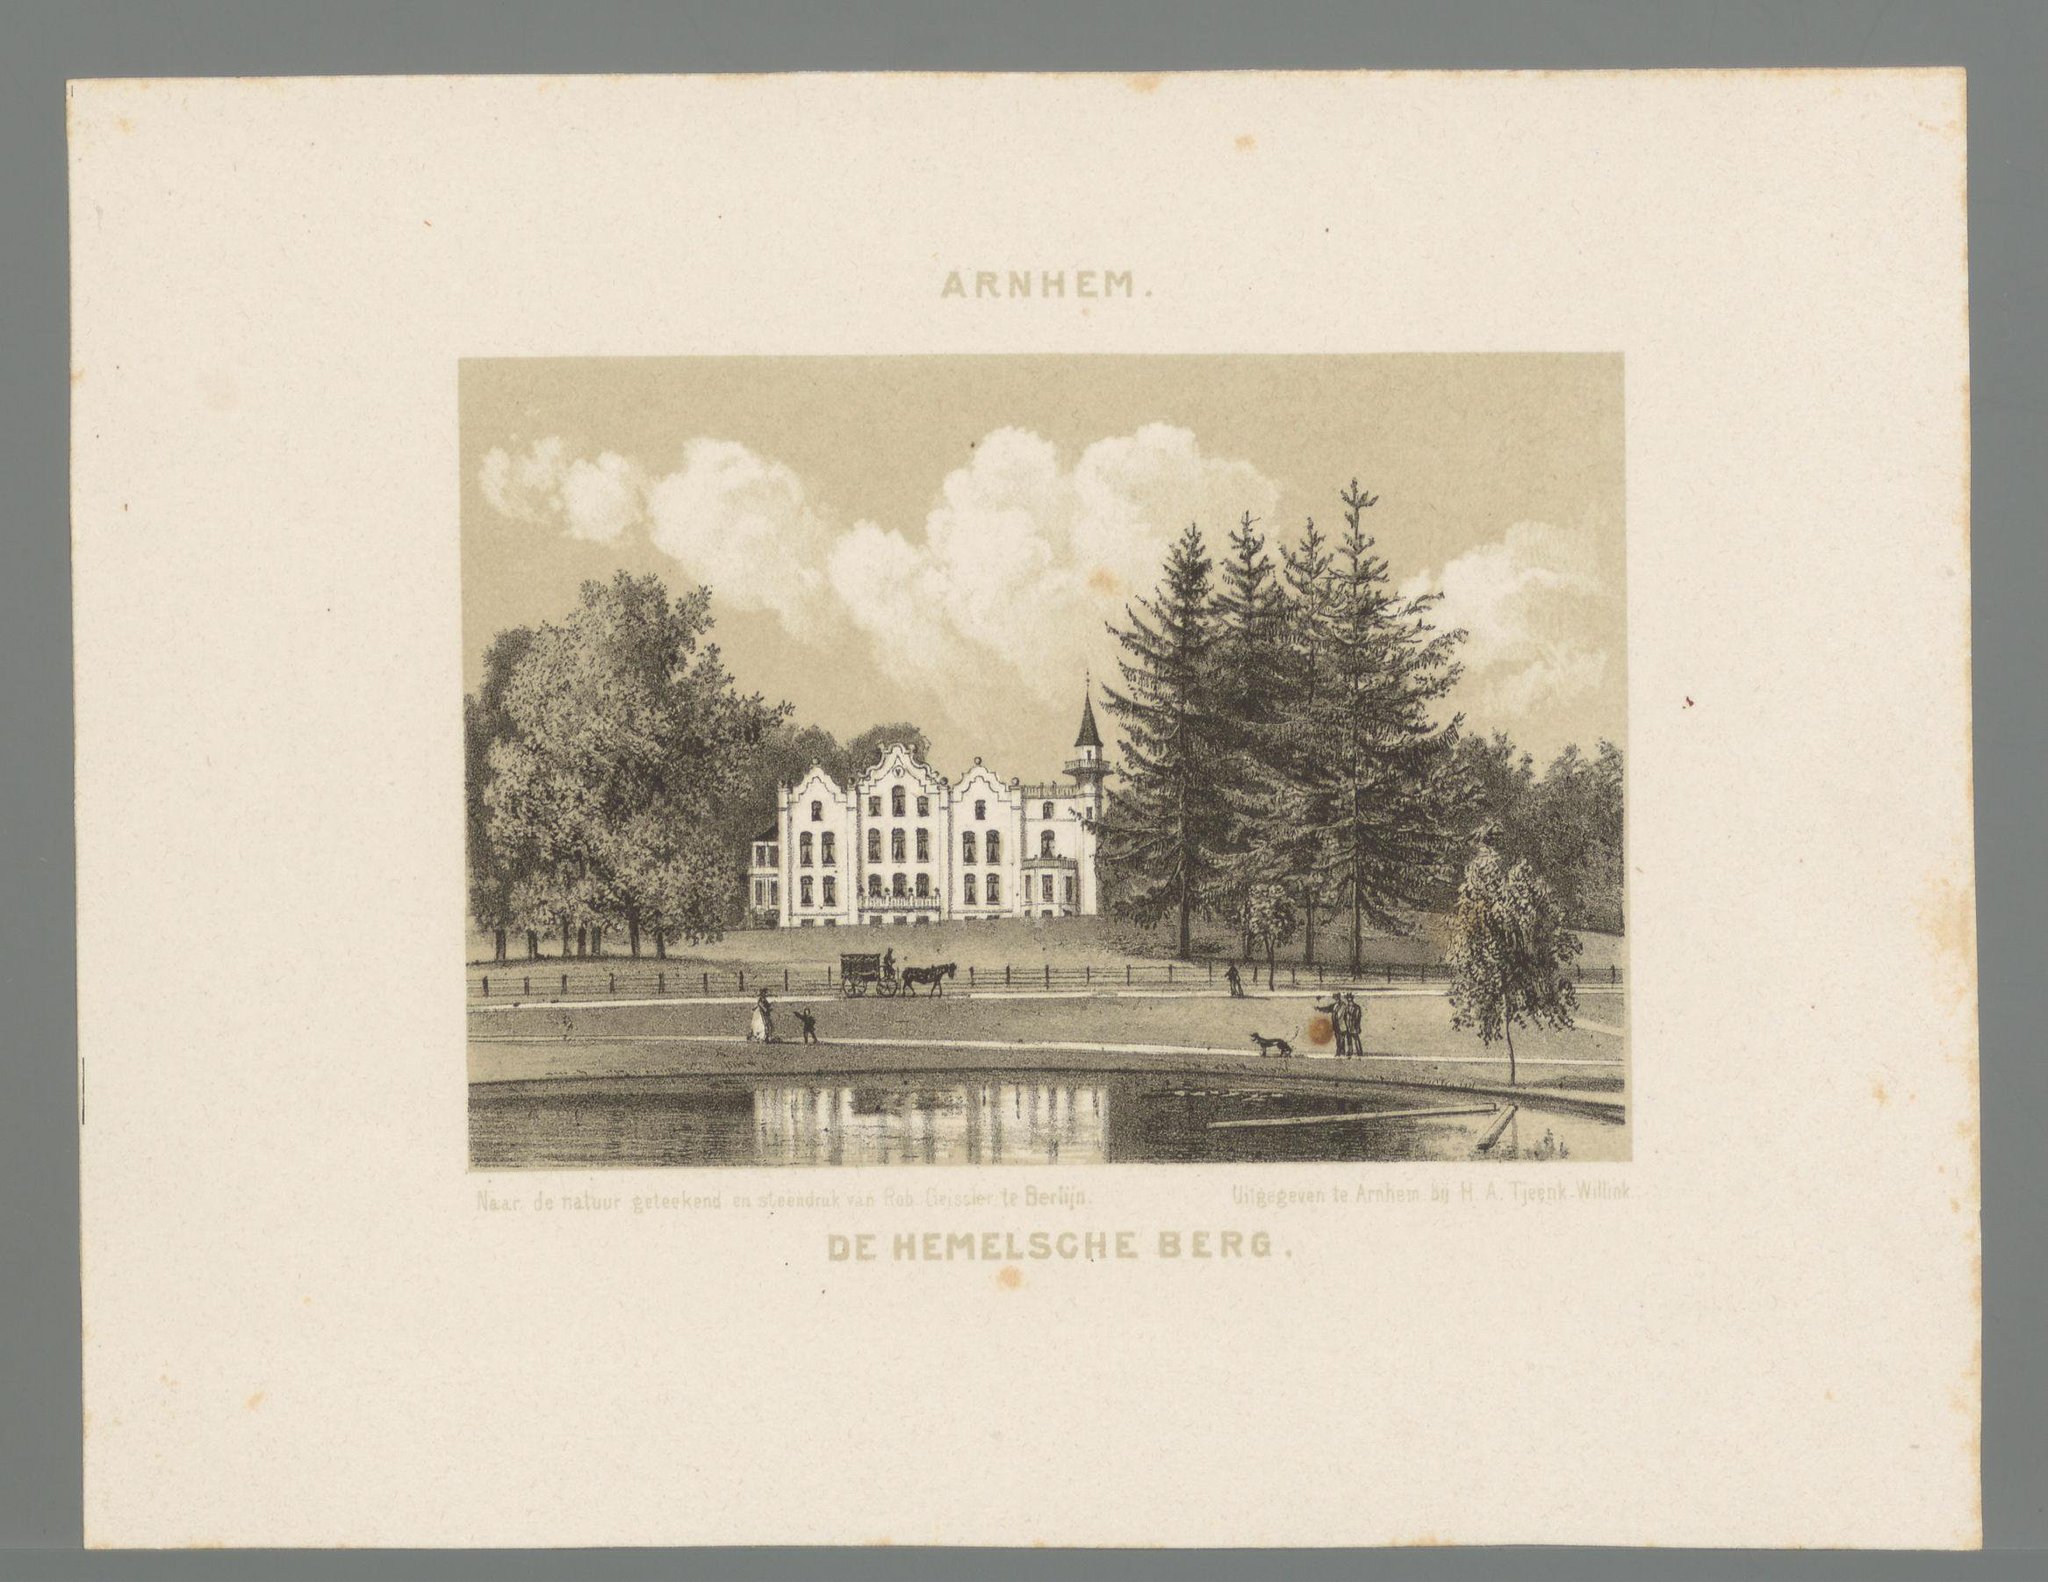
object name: print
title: Souvenir aan Arnhem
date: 1865-1875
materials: paper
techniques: tone lithography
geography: arnhem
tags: rural housing, e.g. country-house, villa, cottage, arnhem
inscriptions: collector's mark: Lugt 2228